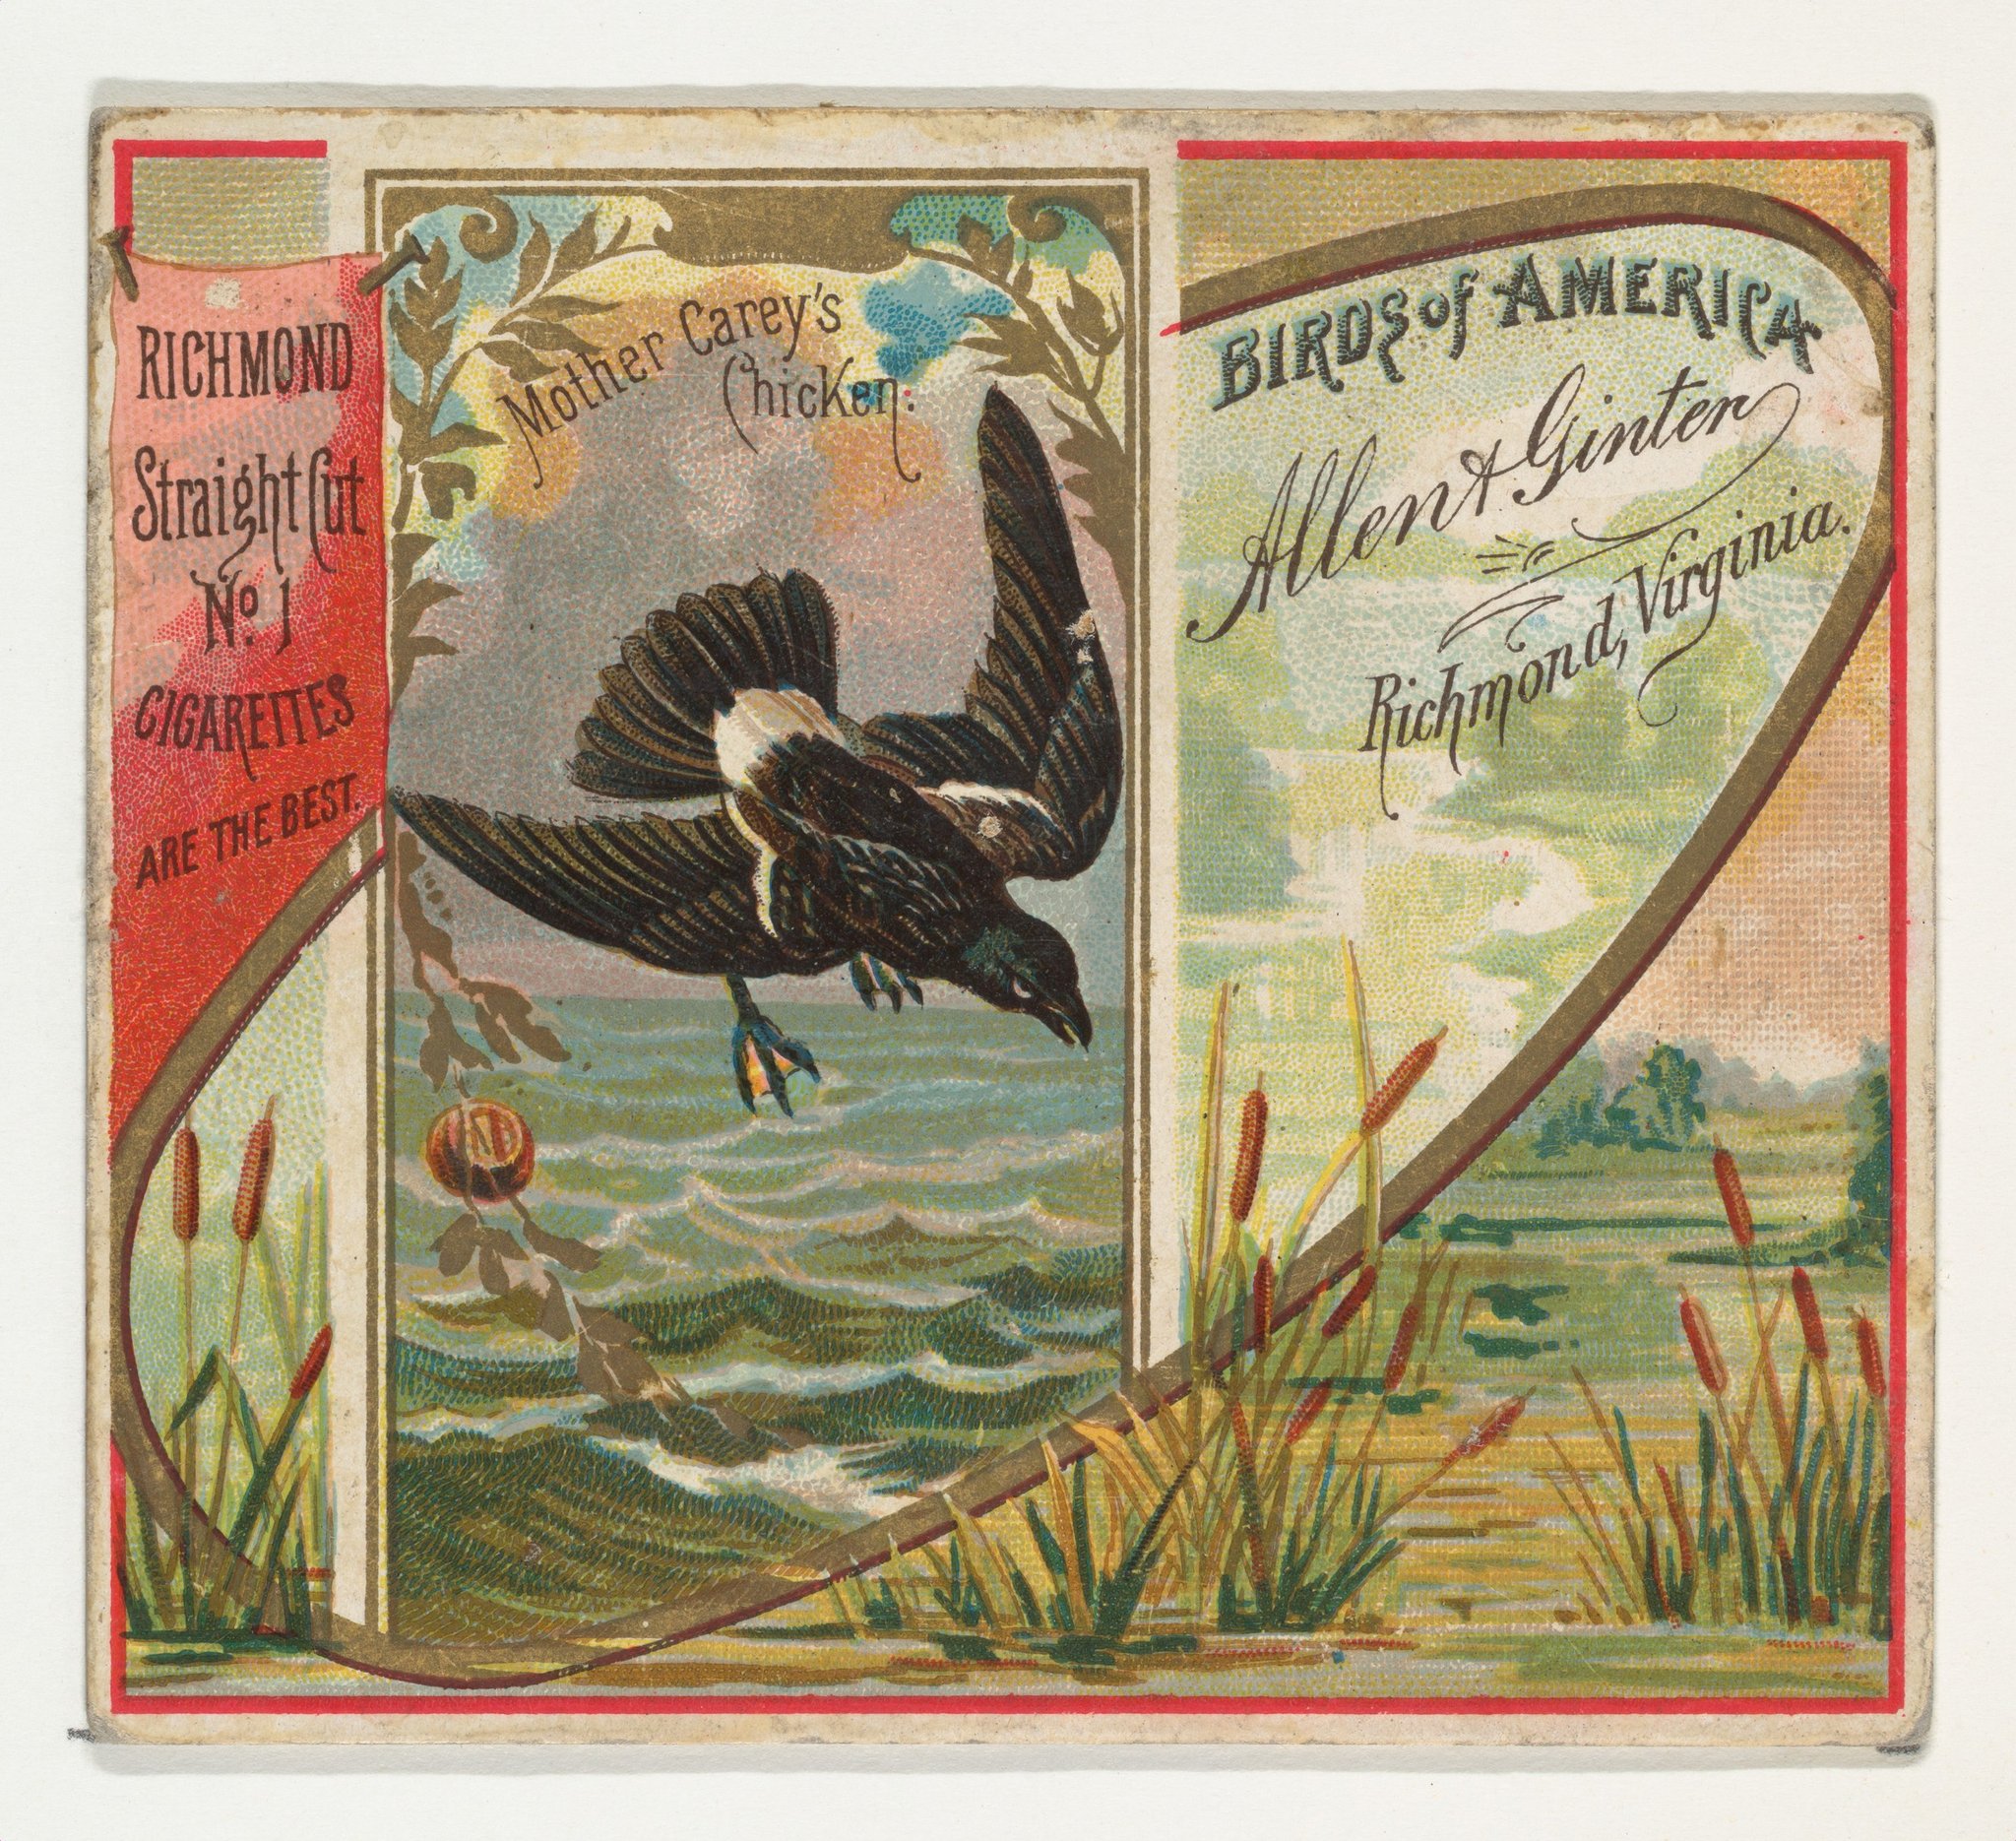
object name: print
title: Mother Carey's Chicken, from the Birds of America series (N37) for Allen & Ginter Cigarettes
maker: allen & ginter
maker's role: publisher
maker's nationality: american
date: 1888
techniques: color lithograph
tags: birds